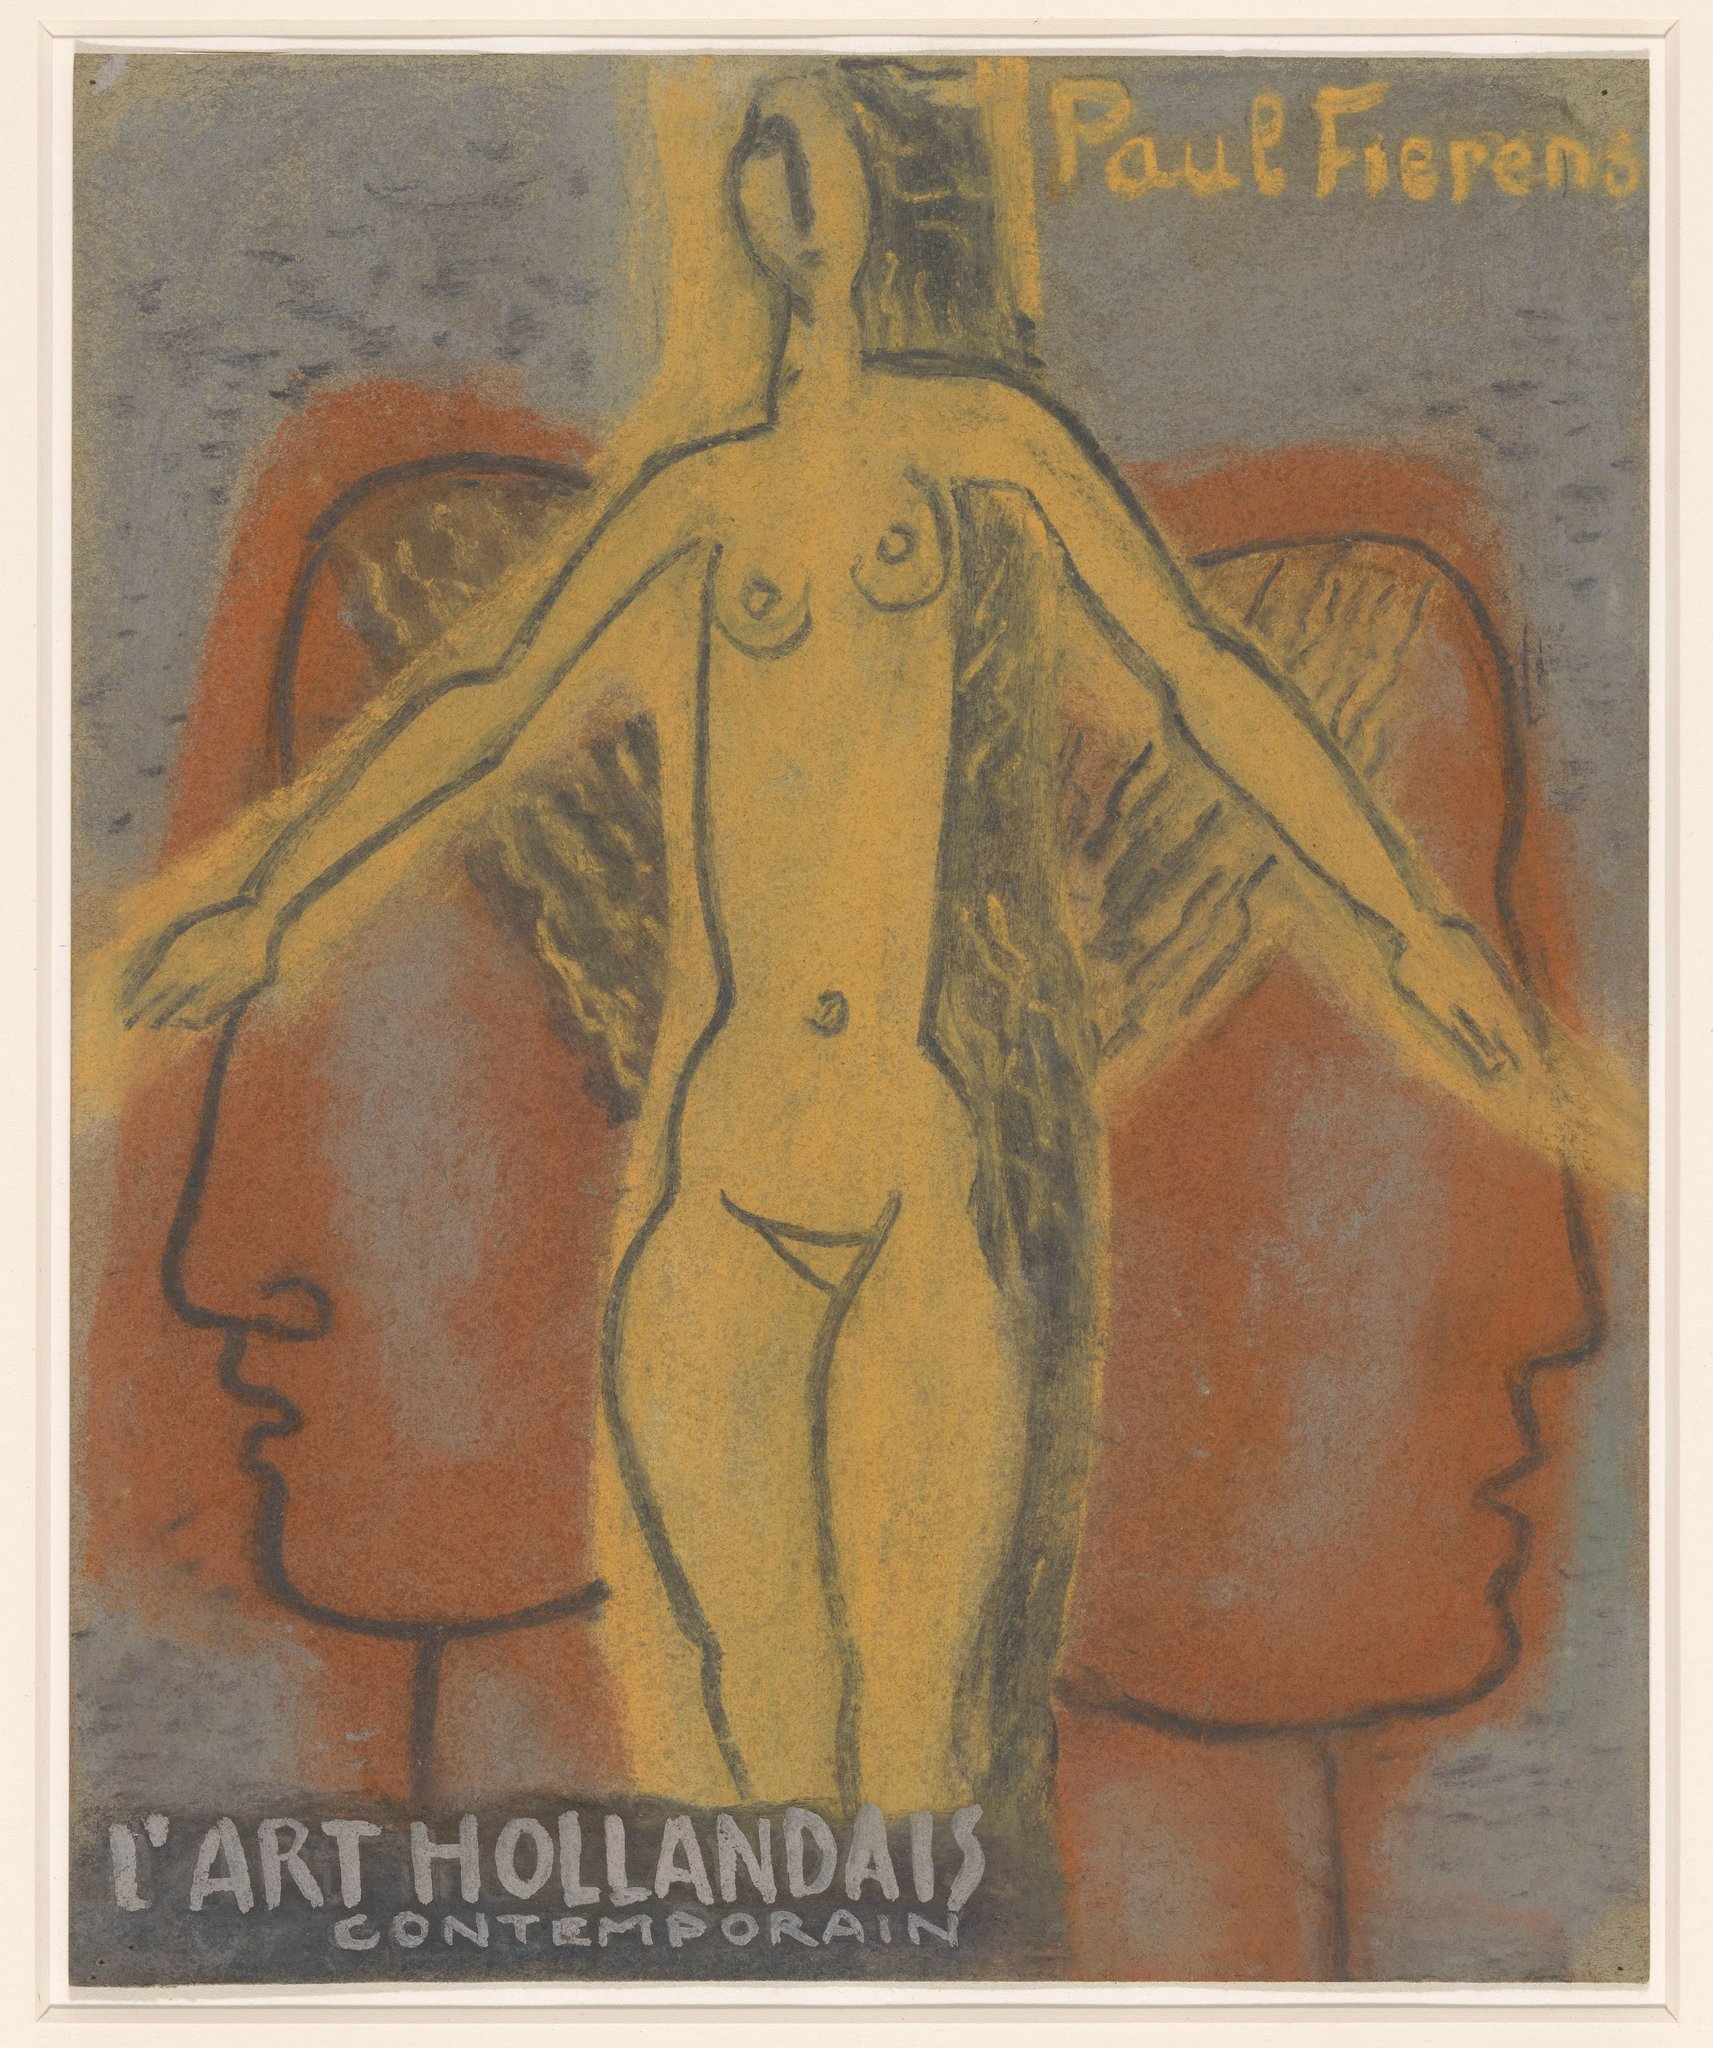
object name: boekomslag ontwerp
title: Omslagontwerp voor: Paul Fierens, L'art hollandais contemporain, 1933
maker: leo gestel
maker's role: draughtsman, print maker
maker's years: 1881-1941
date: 1931-1933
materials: chalk, paint, paper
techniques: brush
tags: face (+ sideview, profile), the (nude) human figure; 'corpo humano' (ripa) - aa - female human figure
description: Ontwerp voor omslag van: Fierens, Paul. L'art hollandais contemporain. Parijs: Le Triangle, [1933].